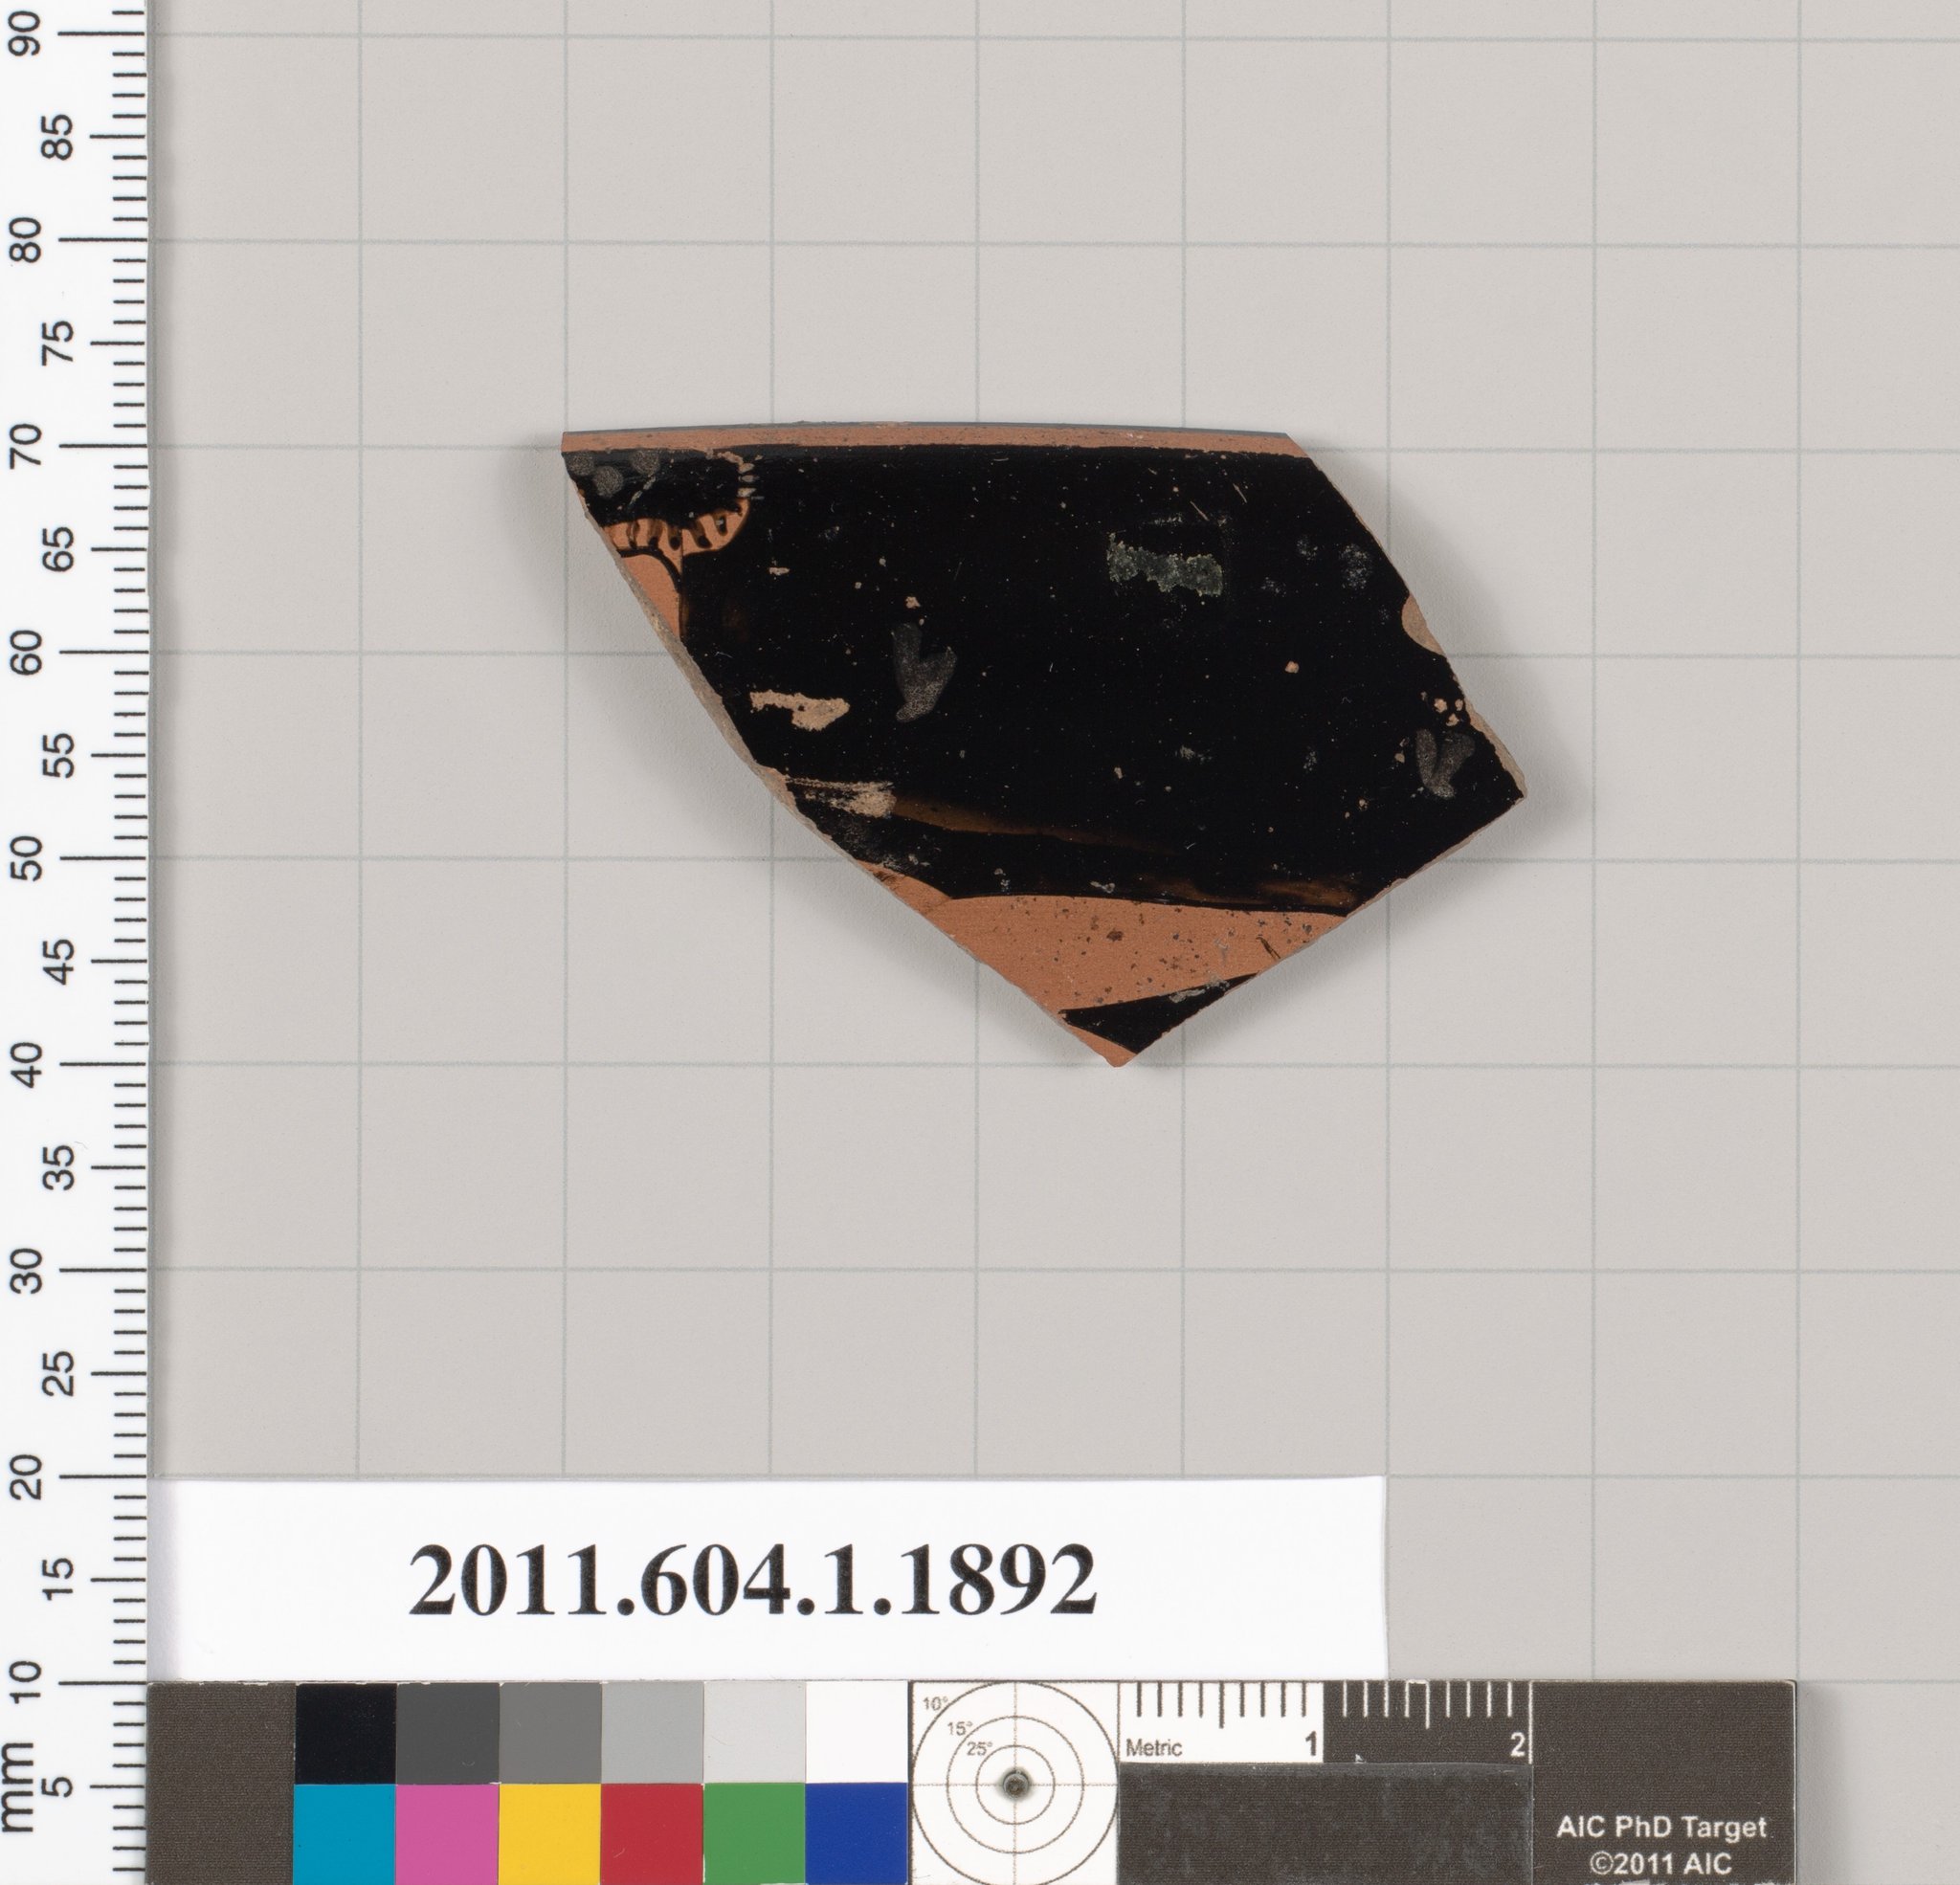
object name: kylix fragment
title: Terracotta rim fragment of a kylix (drinking cup)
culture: greek, attic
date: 520-510 BCE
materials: terracotta